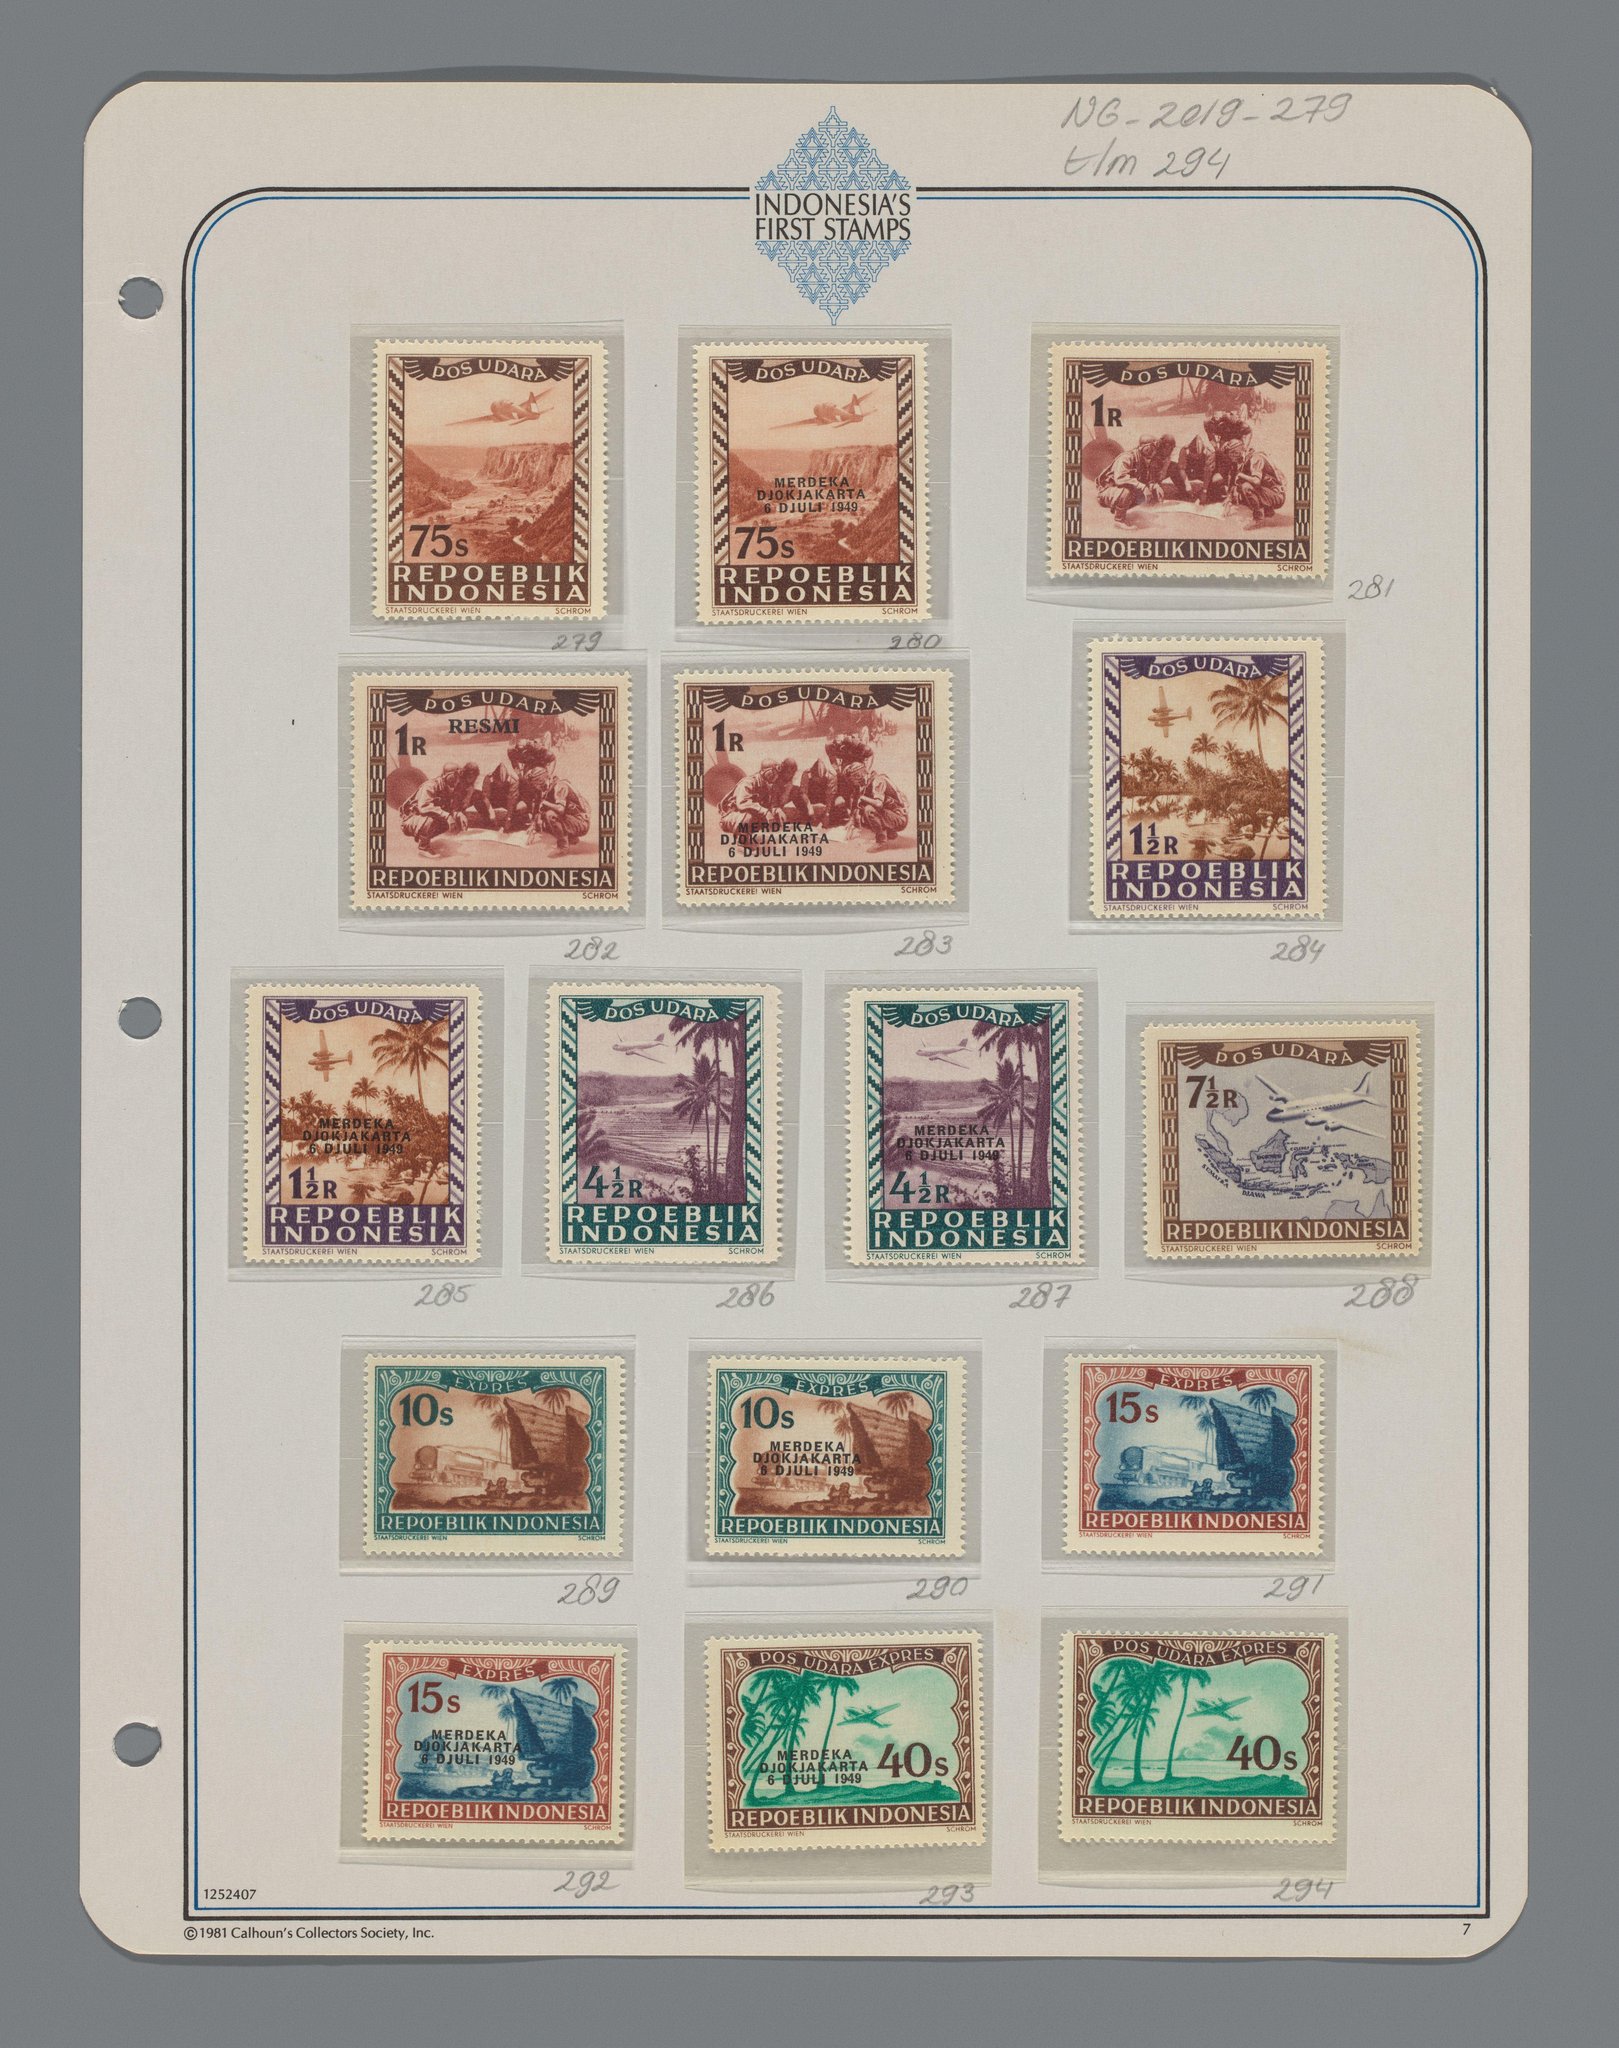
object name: postage stamp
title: Postzegel Republik Indonesia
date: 1949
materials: paper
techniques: photoaquatint, engraving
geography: philadelphia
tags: indonesia